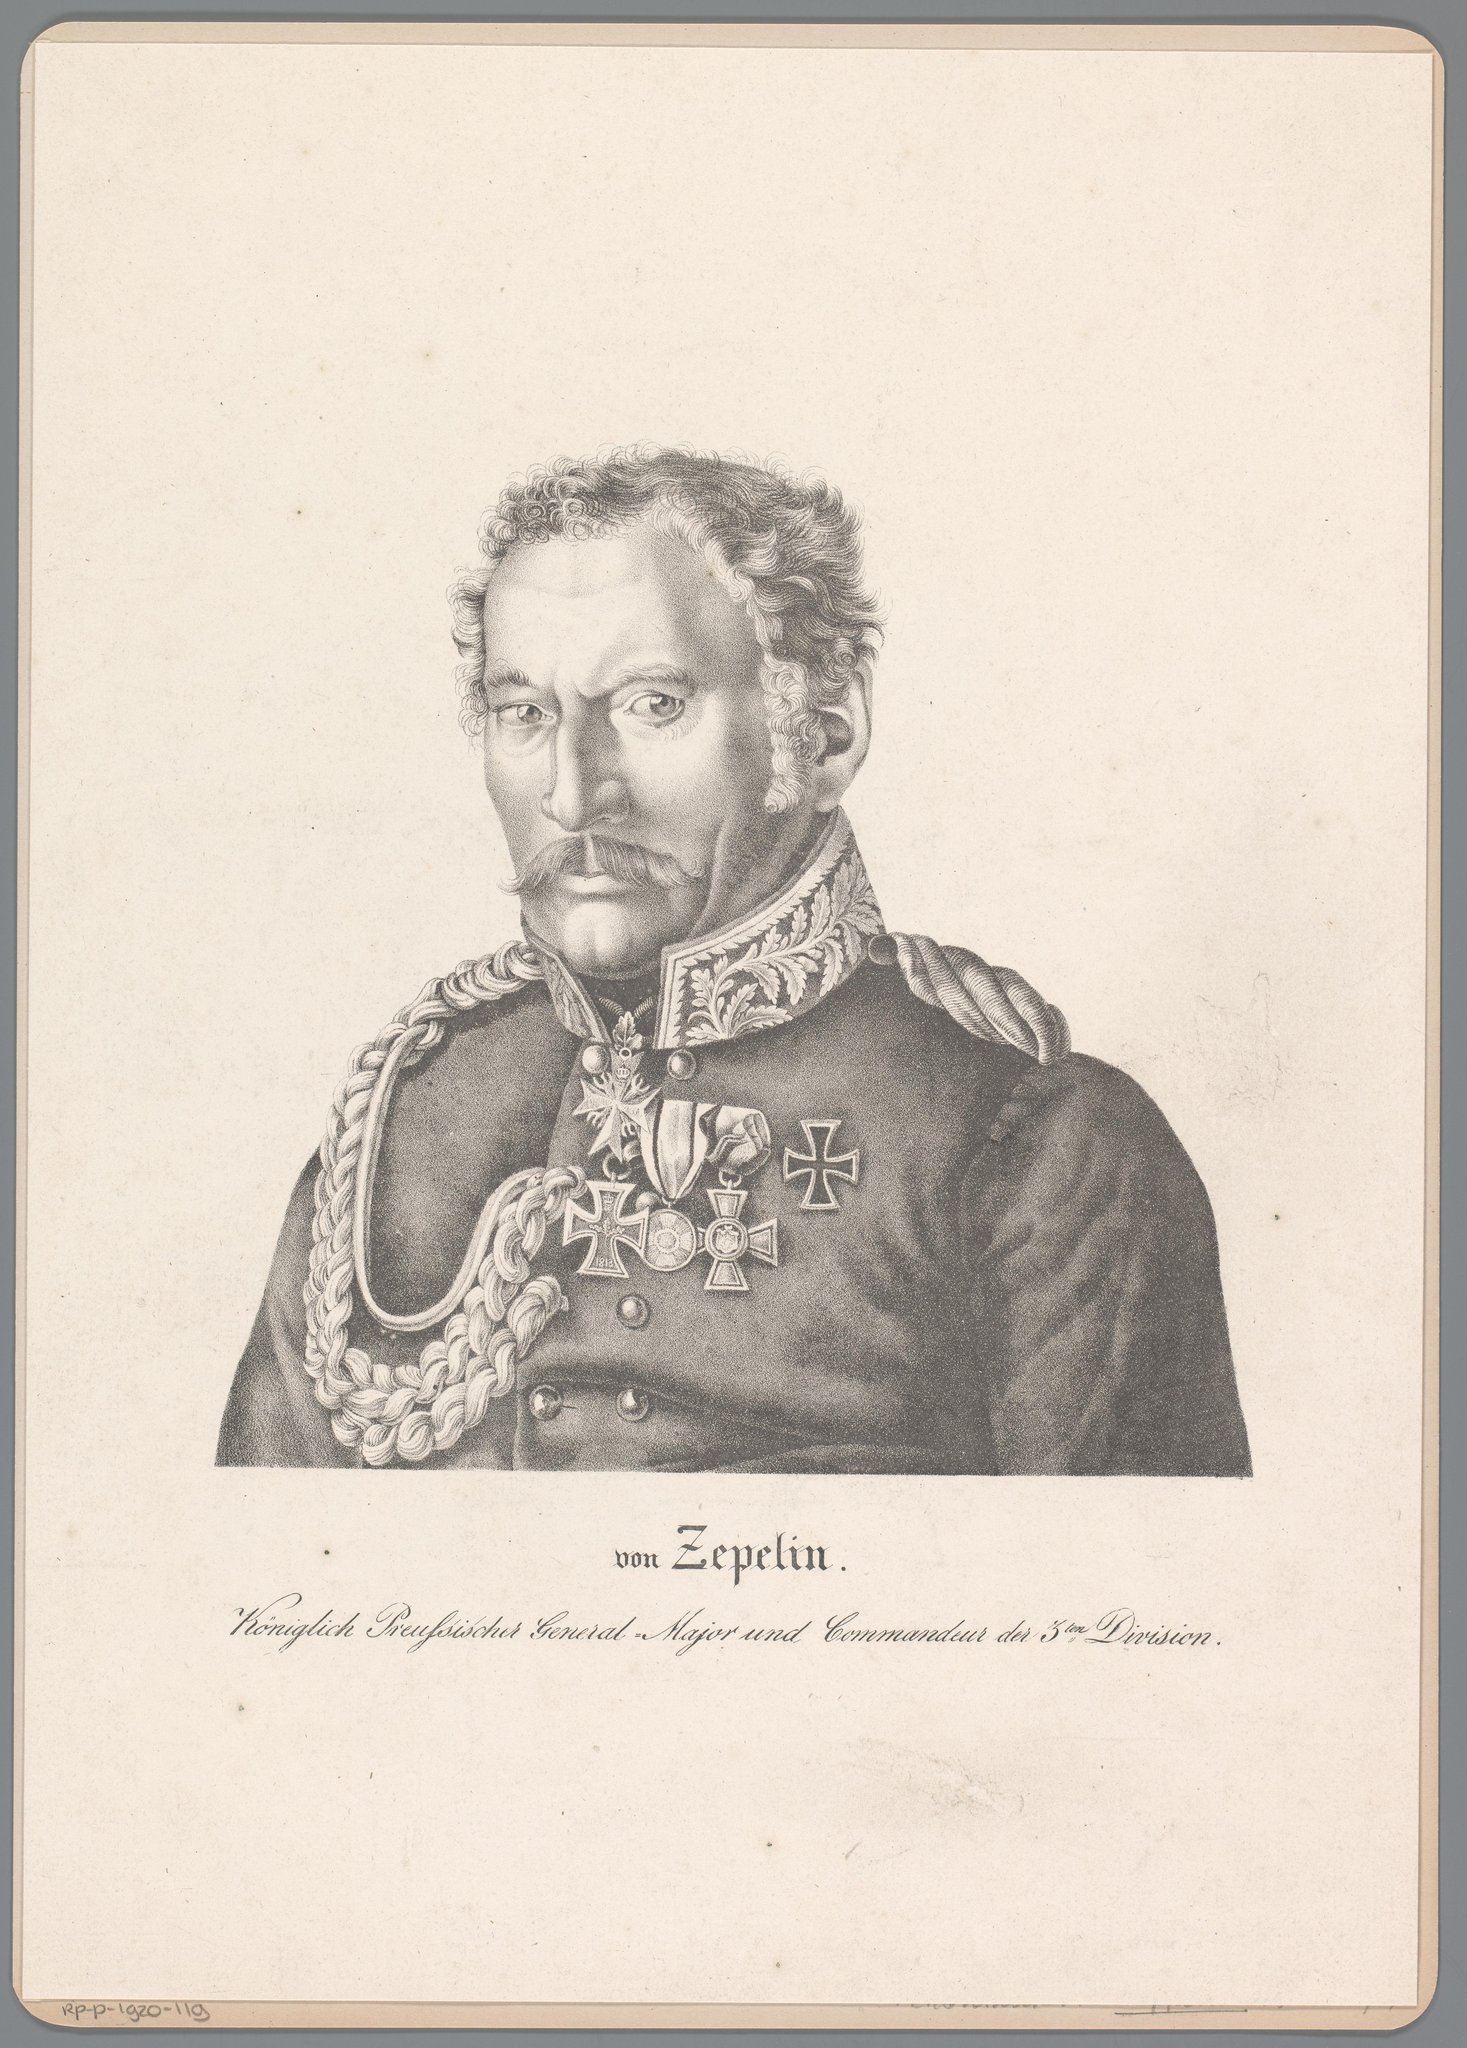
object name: print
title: Portret van Ferdinand von Zeppelin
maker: Anonymous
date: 1882-1890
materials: paper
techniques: lithograph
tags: engineer, commander-in-chief, general, marshal, historical persons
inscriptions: collector's mark: Lugt 2228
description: Met eenregelig onderschrift in het Duits.